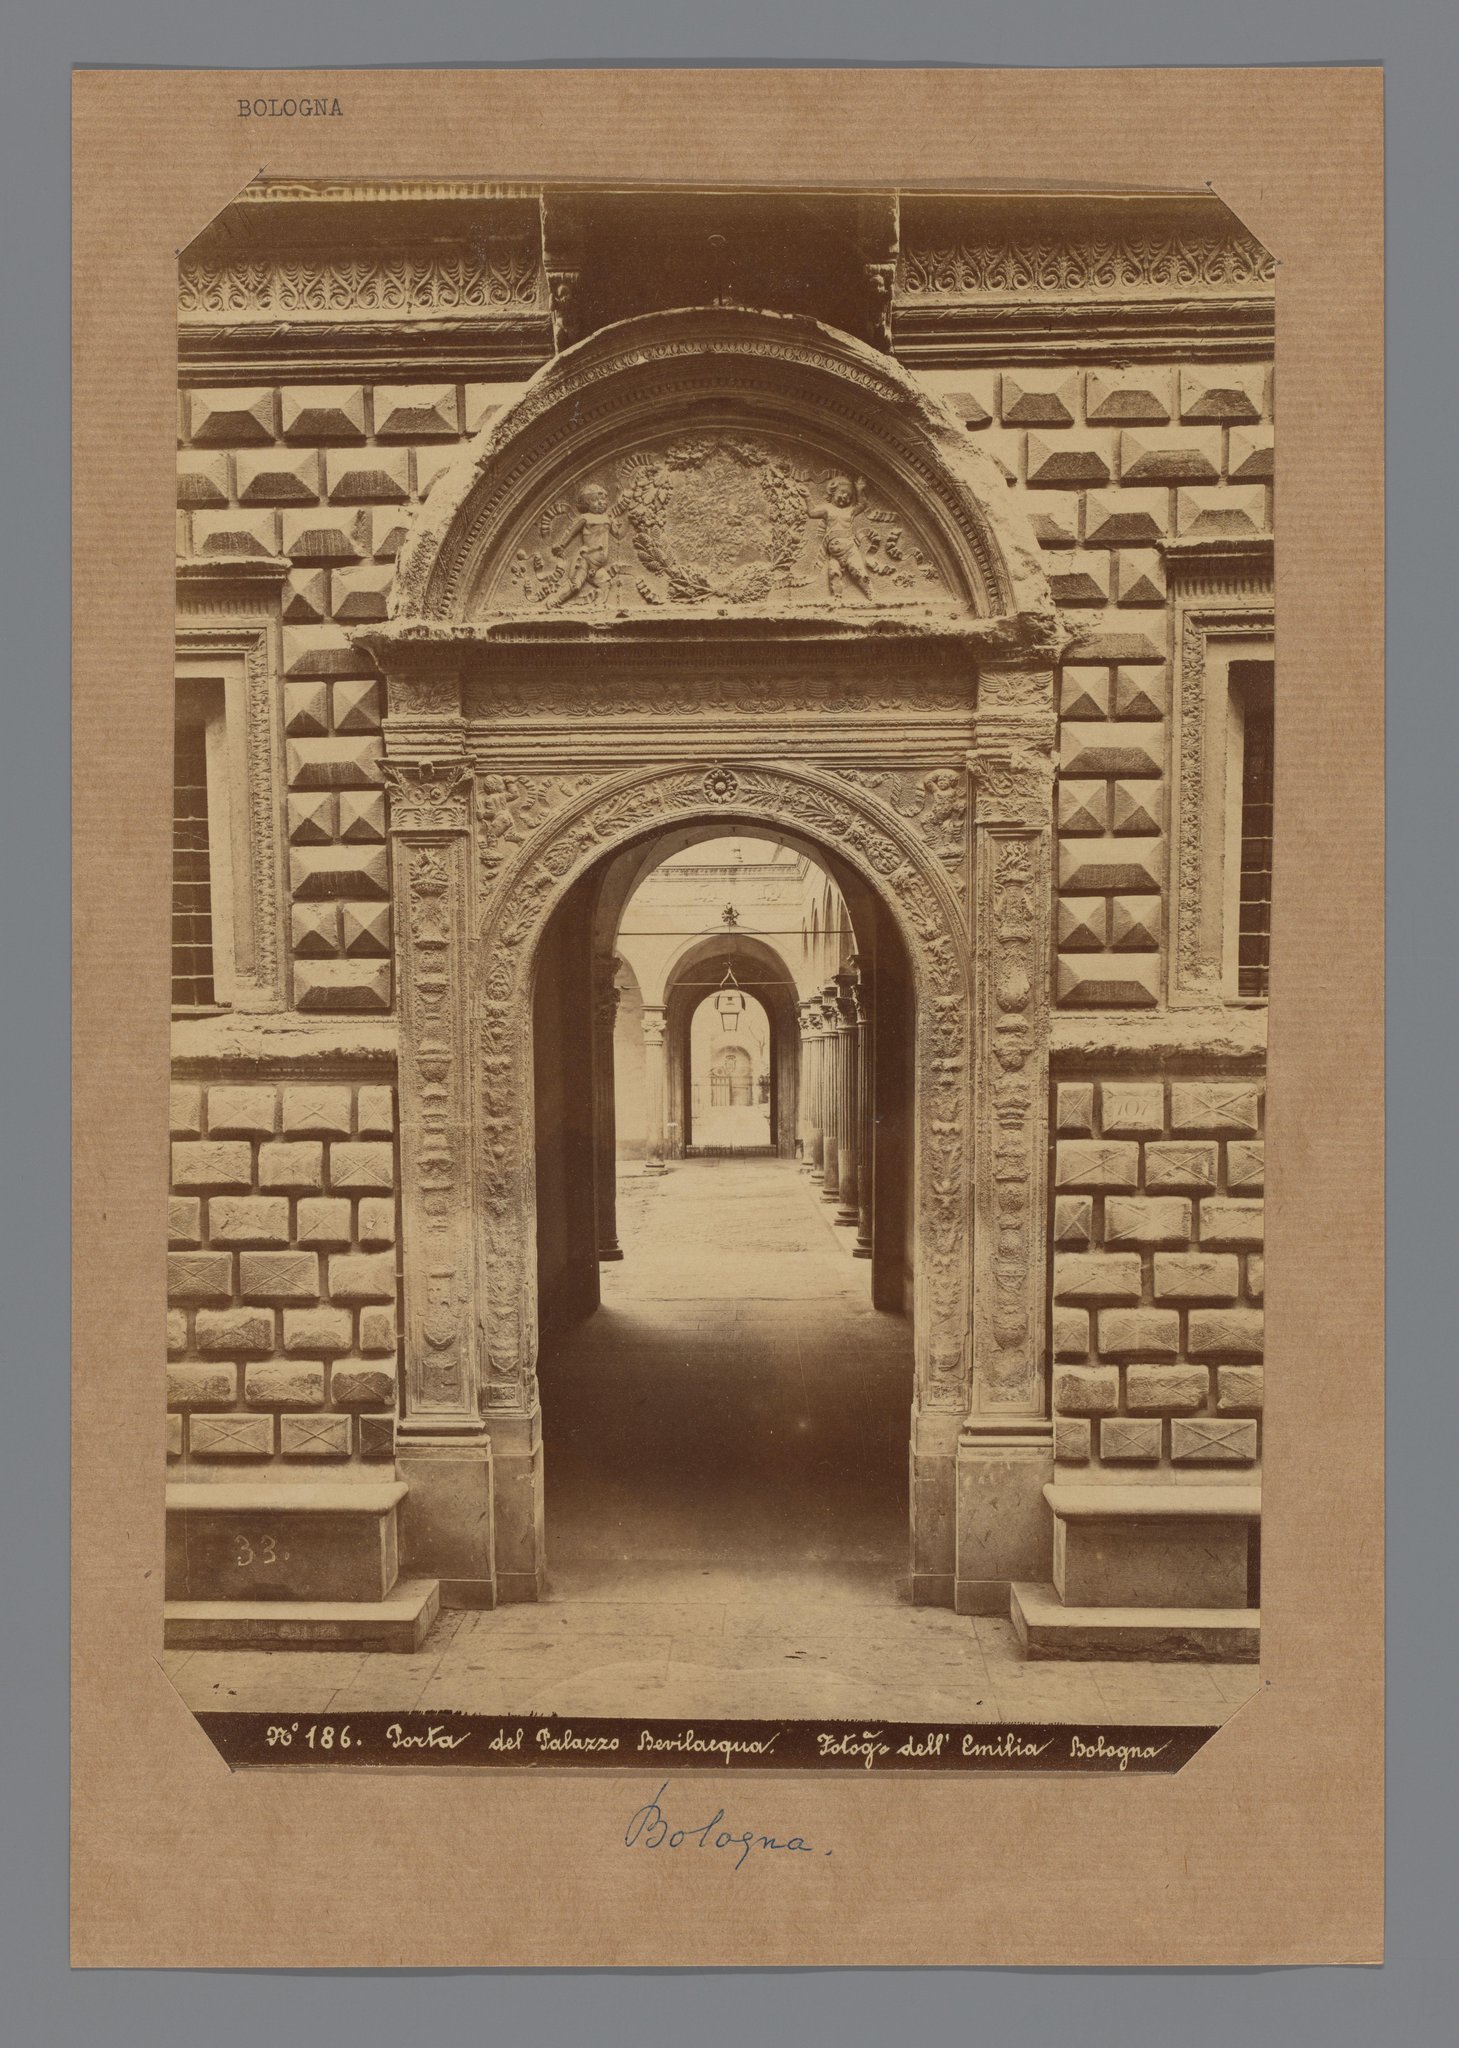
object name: photograph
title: Italië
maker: Anonymous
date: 1880-1910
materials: photographic support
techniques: albumen print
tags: italy